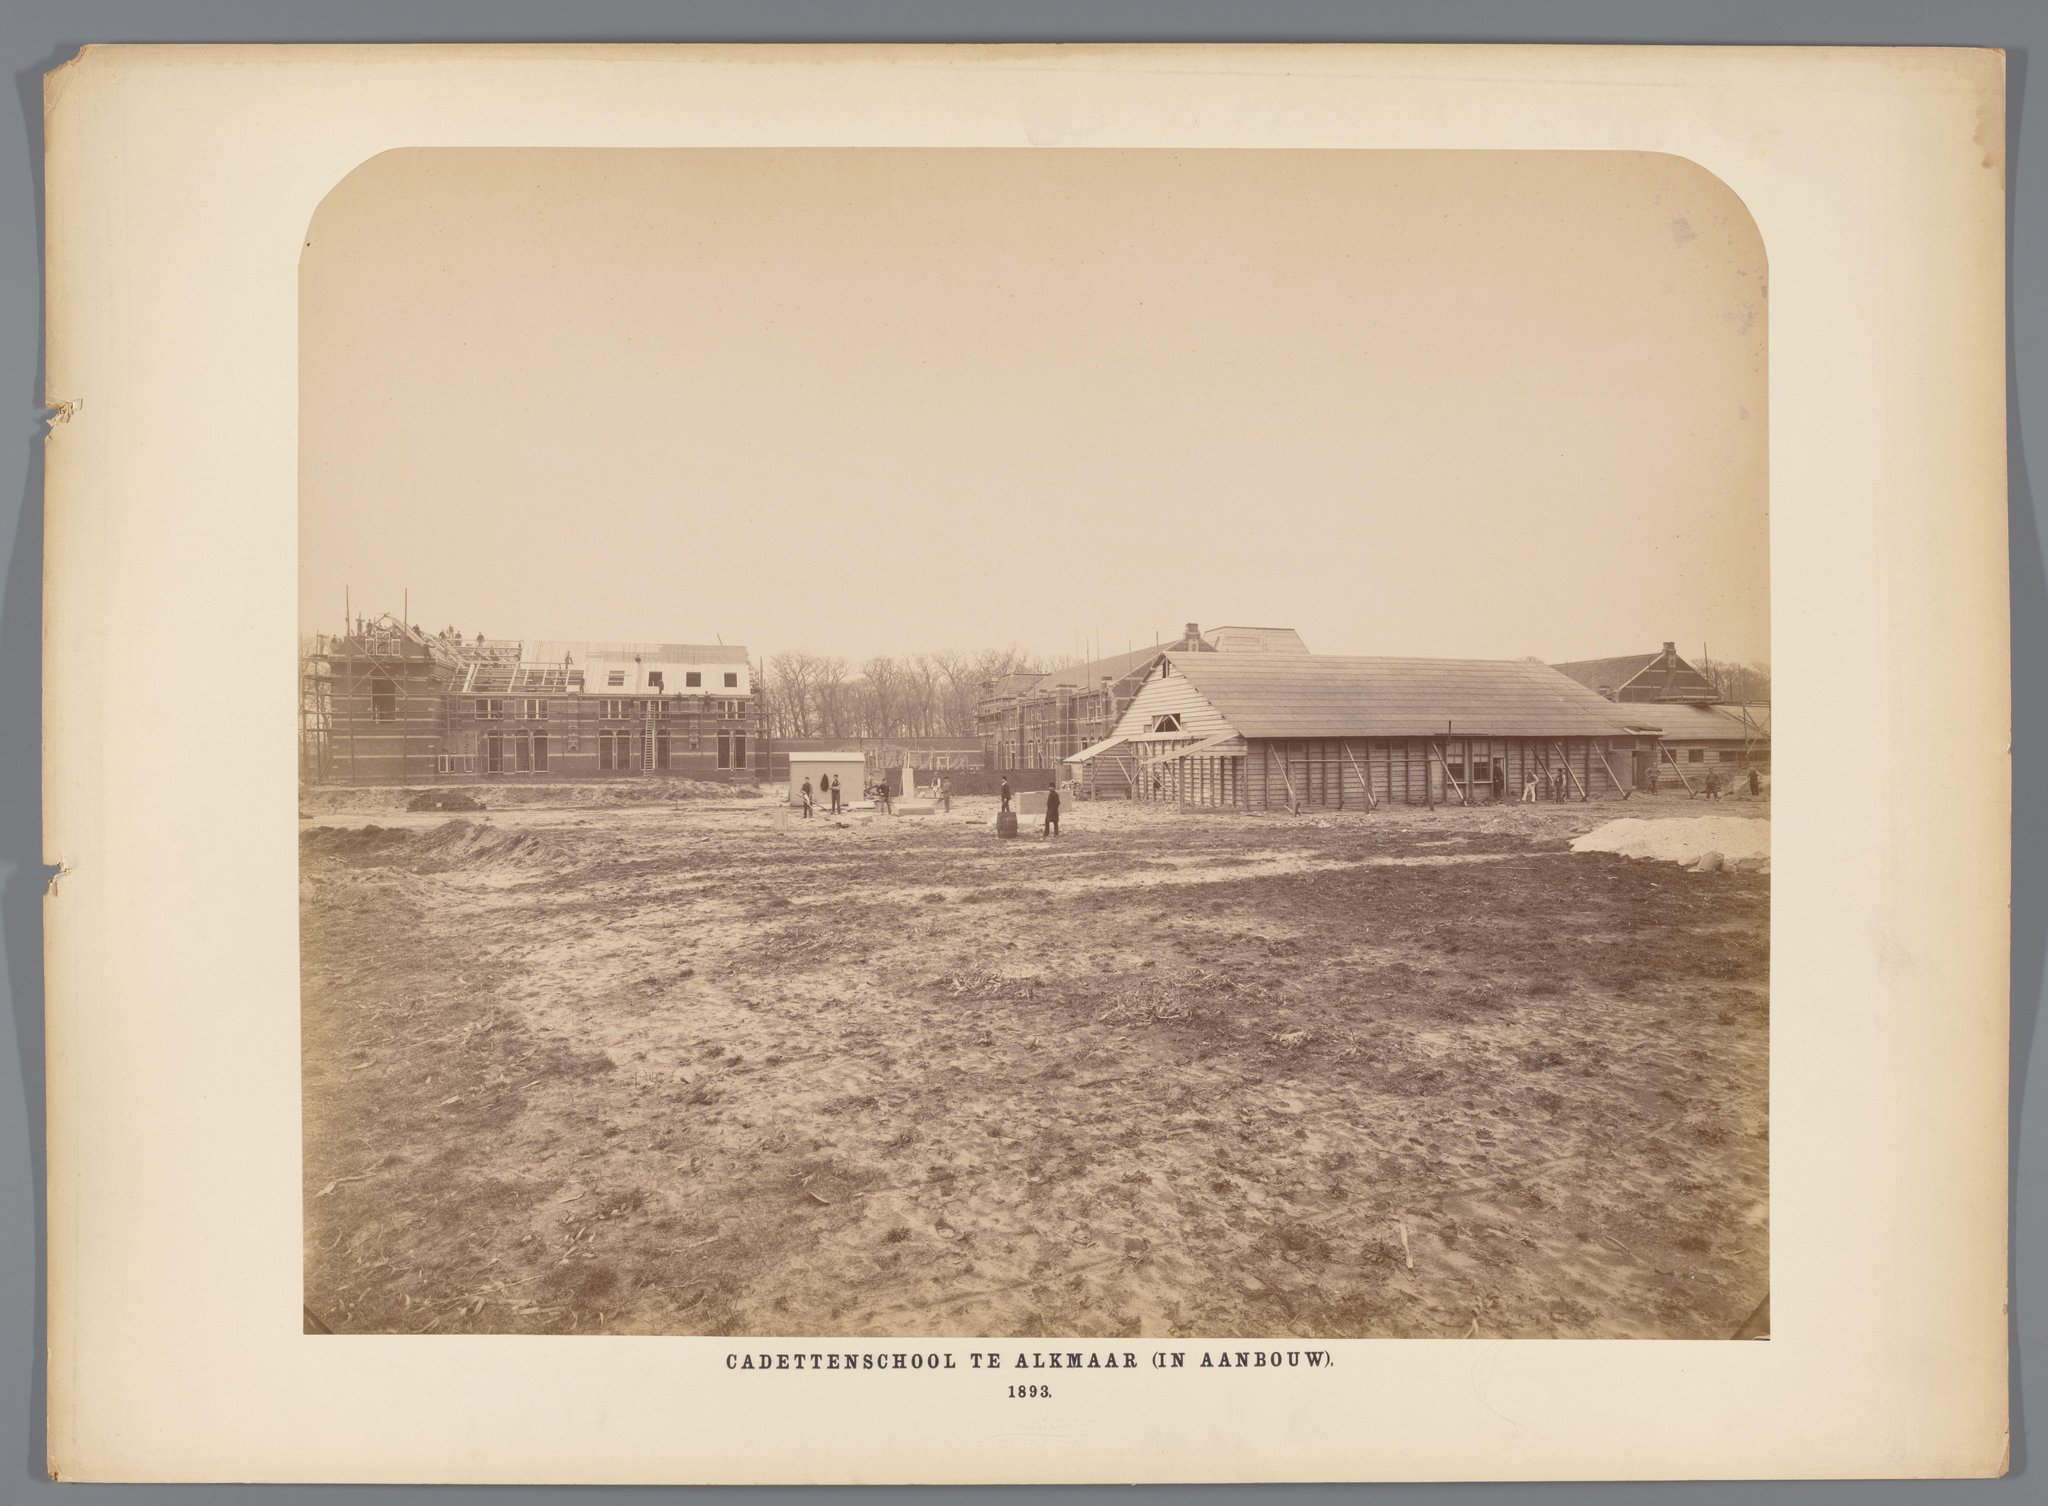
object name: photograph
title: Cadettenschool te Alkmaar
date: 1893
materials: cardboard, paper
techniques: photography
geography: alkmaar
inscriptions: date